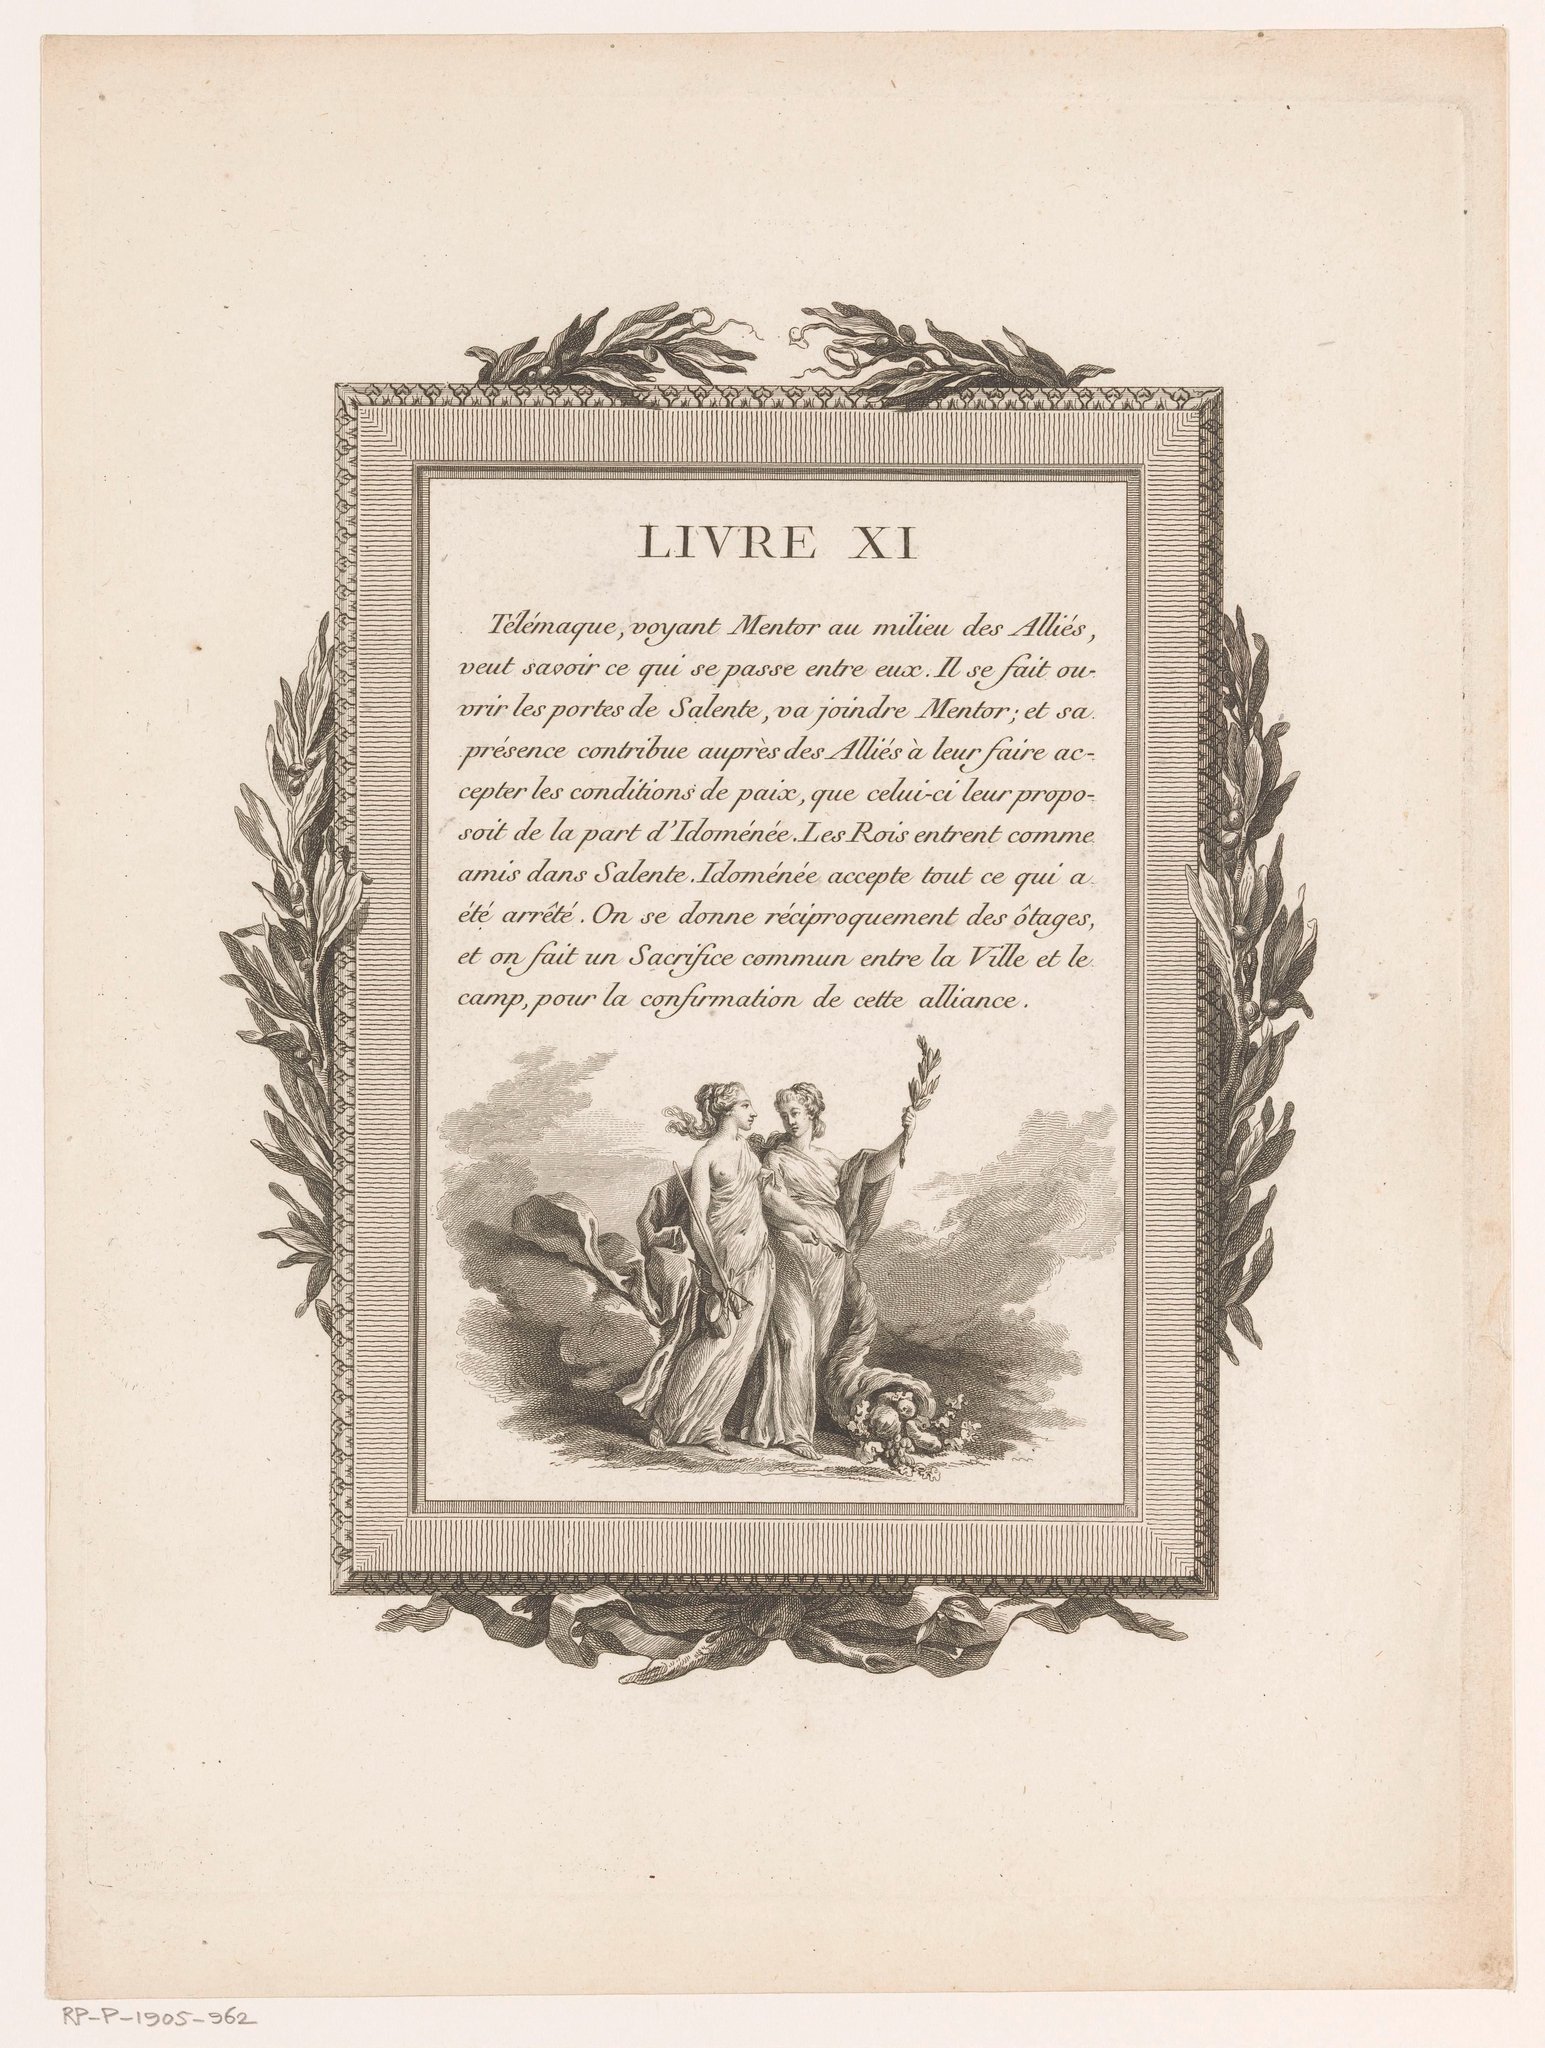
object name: print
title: Omkaderde Franse tekst met olijftakken en twee allegorische figuren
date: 1785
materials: paper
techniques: engraving, etching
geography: france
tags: (fenelon, telemachus) specific works of literature (with author, title), ornament ~ festoon, garland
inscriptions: collector's mark: Lugt 2228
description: Tienregelige Franse tekst, getiteld 'Livre XI' met daaronder een afbeelding van de allegorische figuren van oorlog, met een zwaard in haar hand, en vrede, met een olijftak en cornucopia. Het geheel wordt gekaderd door een sierlijst met olijftakken en onderaan een strik.